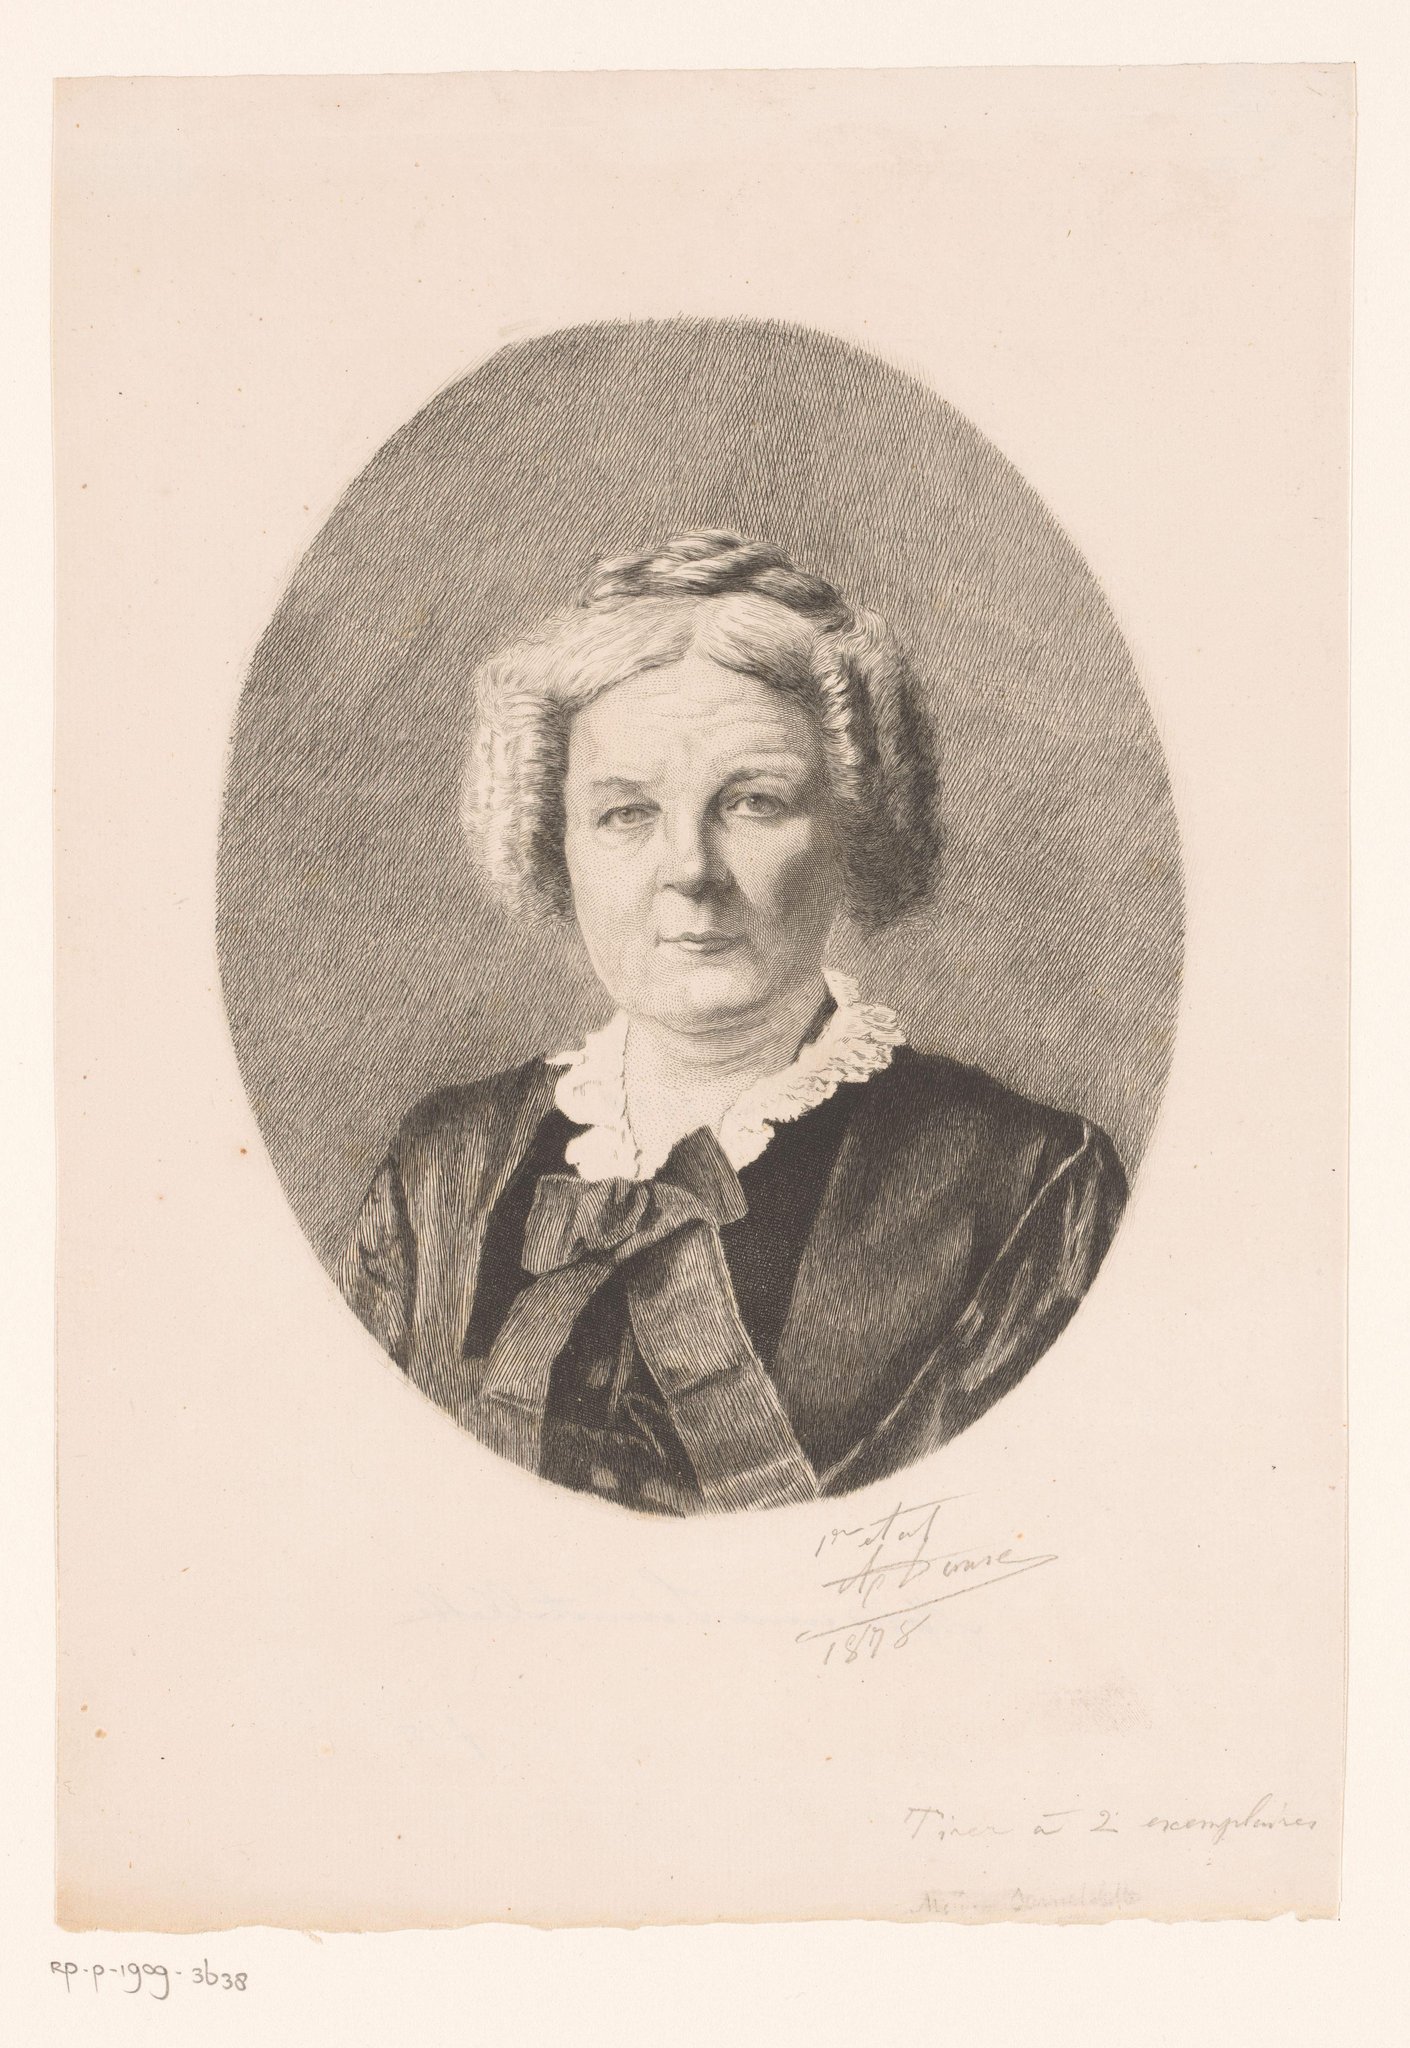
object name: print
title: Portret van een onbekende dame, mevrouw Sainctelette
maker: auguste danse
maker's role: print maker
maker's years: 1829-1929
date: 1878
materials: paper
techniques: drypoint, etching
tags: anonymous historical person portrayed alone - bb - woman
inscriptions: annotation: ‘1er état’, watermark: ‘Franse lelie in wapenschild boven monogram VGZ’, annotation: ‘Tirer á 2 exemplaires’, collector's mark: Lugt 2228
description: De naam Sainctelette is gebaseerd op een potloodaantekening in de marge van een andere staat van deze prent.